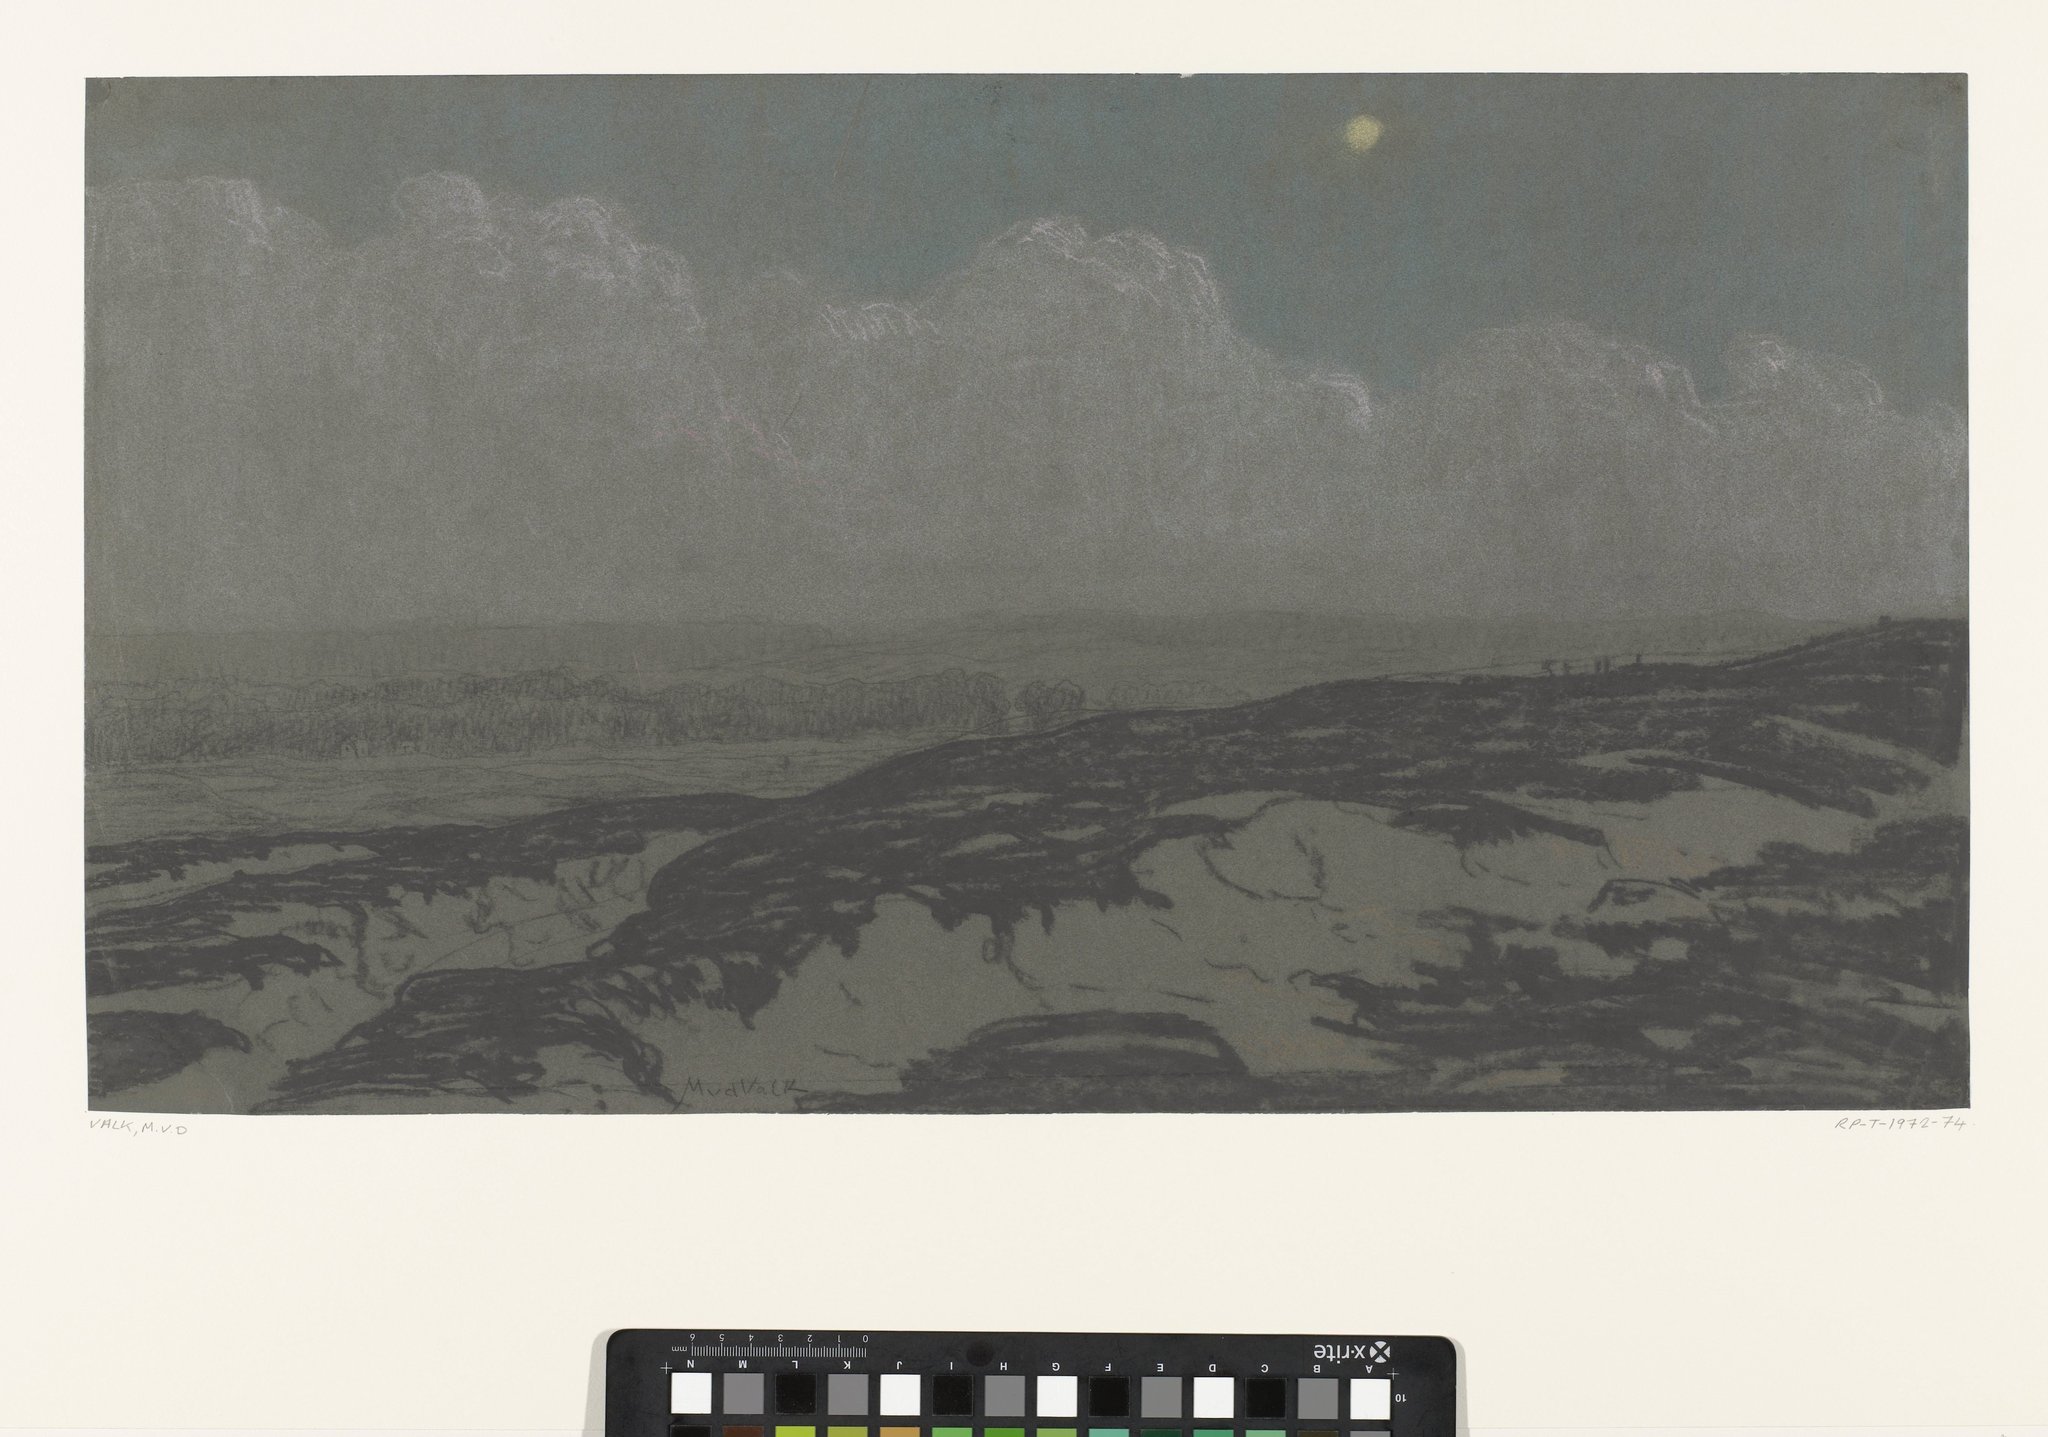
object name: drawing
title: Landschap bij maanlicht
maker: maurits van der valk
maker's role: draughtsman, print maker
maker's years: 1857-1935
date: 1867-1935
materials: chalk, charcoal, paper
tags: landscapes in the temperate zone, night ~ landscape (sometimes titled 'nox')